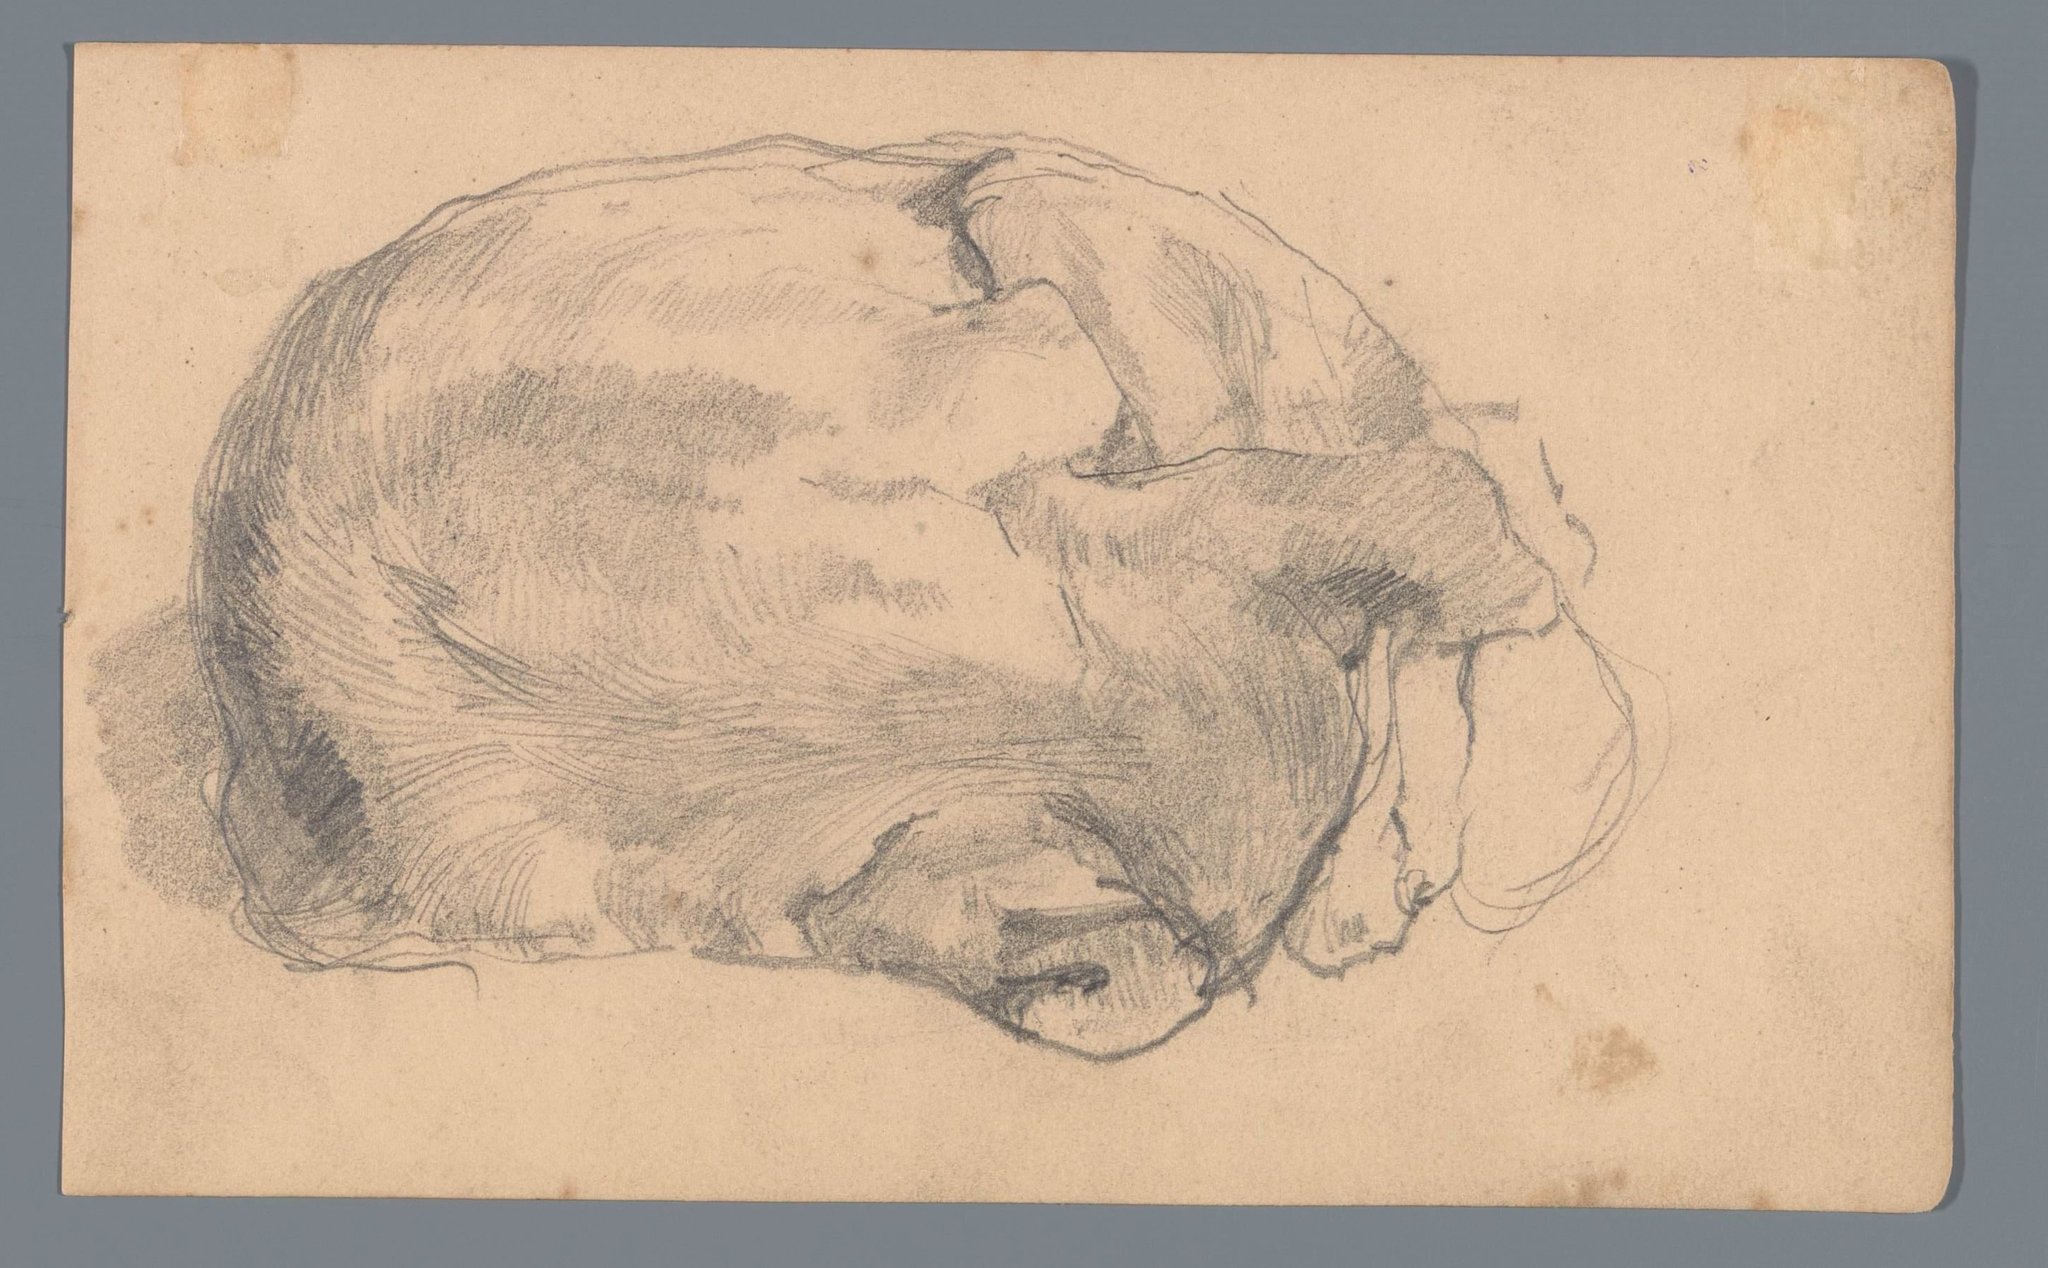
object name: drawing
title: Liggende hond of kat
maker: george hendrik breitner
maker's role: draughtsman, painter, print maker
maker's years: 1857-1923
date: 1880-1882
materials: paper, pencil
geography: rotterdam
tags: cat